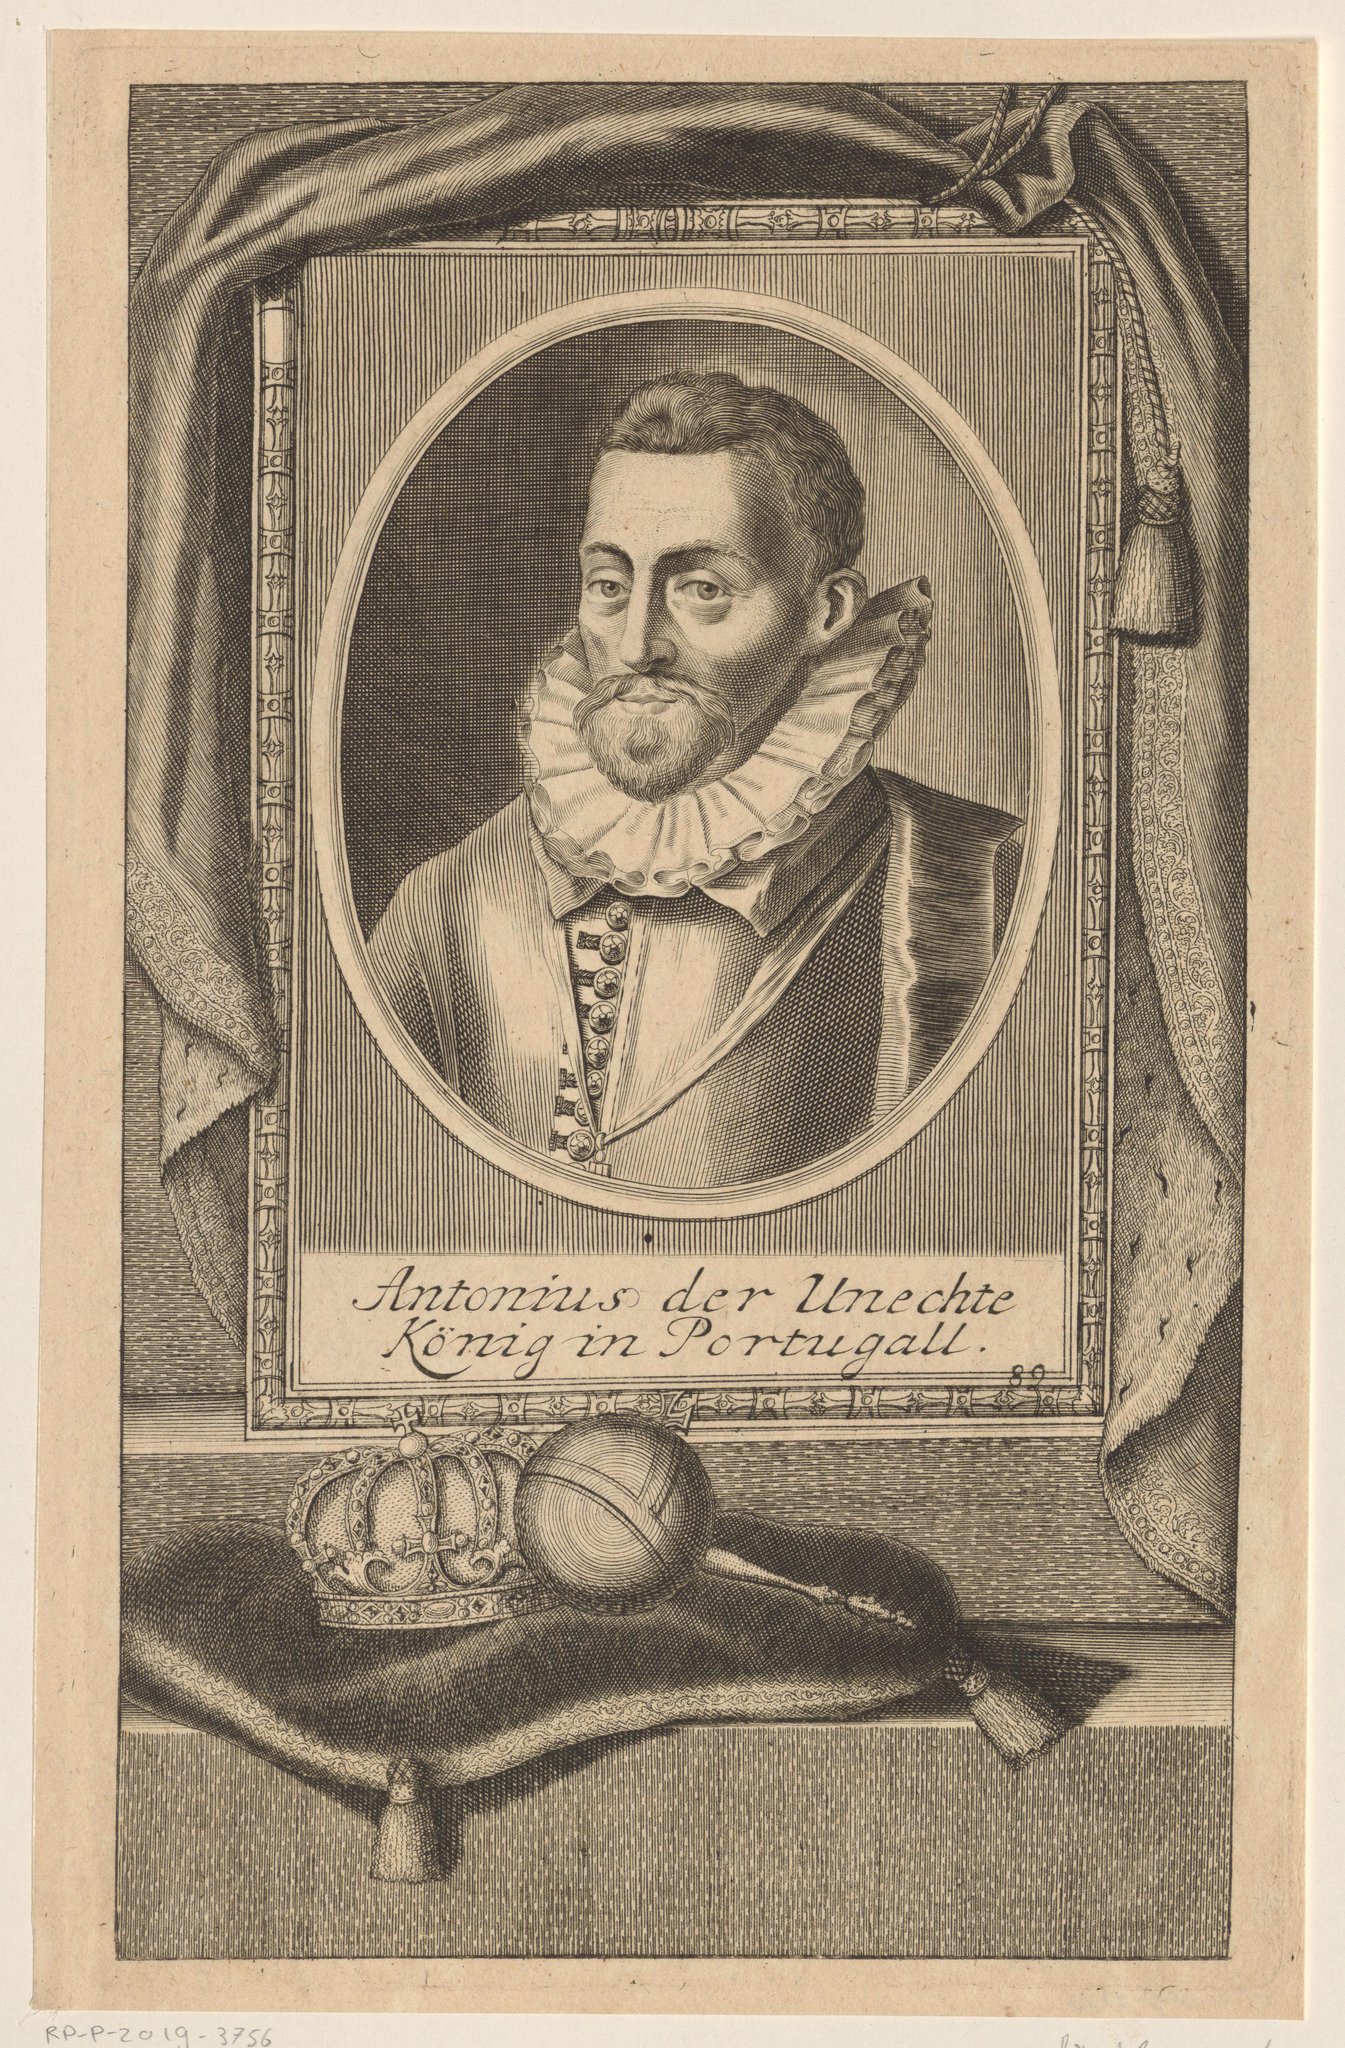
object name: print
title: Portret van Anton I, koning van Portugal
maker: Anonymous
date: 1600-1699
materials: paper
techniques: engraving, etching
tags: crown (symbol of sovereignty), historical persons